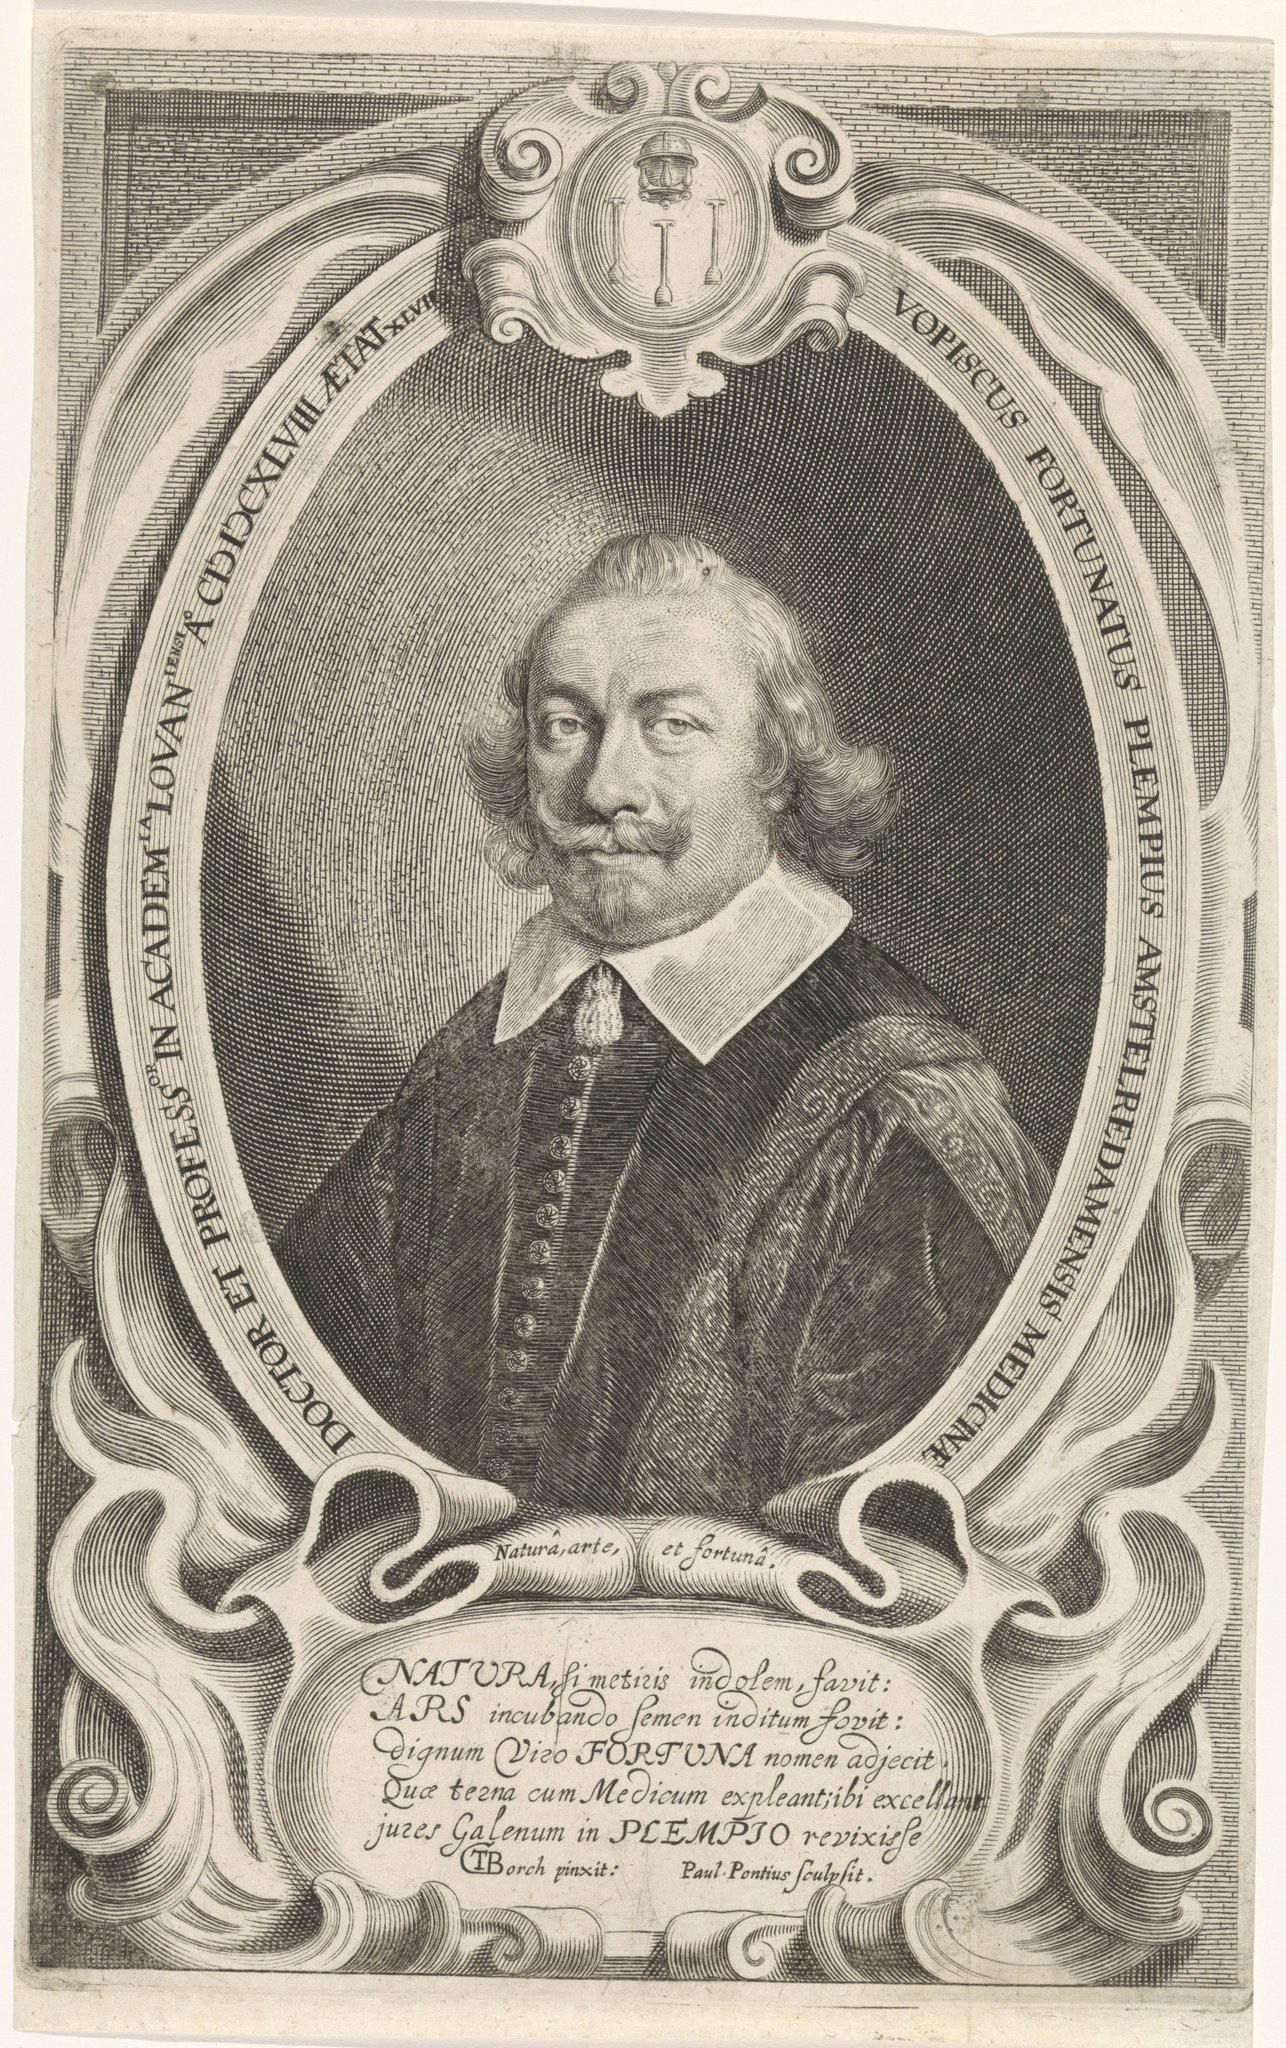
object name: print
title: Portret van Vopiscus Fortunatus Plempius op 47-jarige leeftijd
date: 1648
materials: paper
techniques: engraving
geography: antwerp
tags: vopiscus fortunatus plempius, historical persons, armorial bearing, heraldry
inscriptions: collector's mark: Lugt 2228